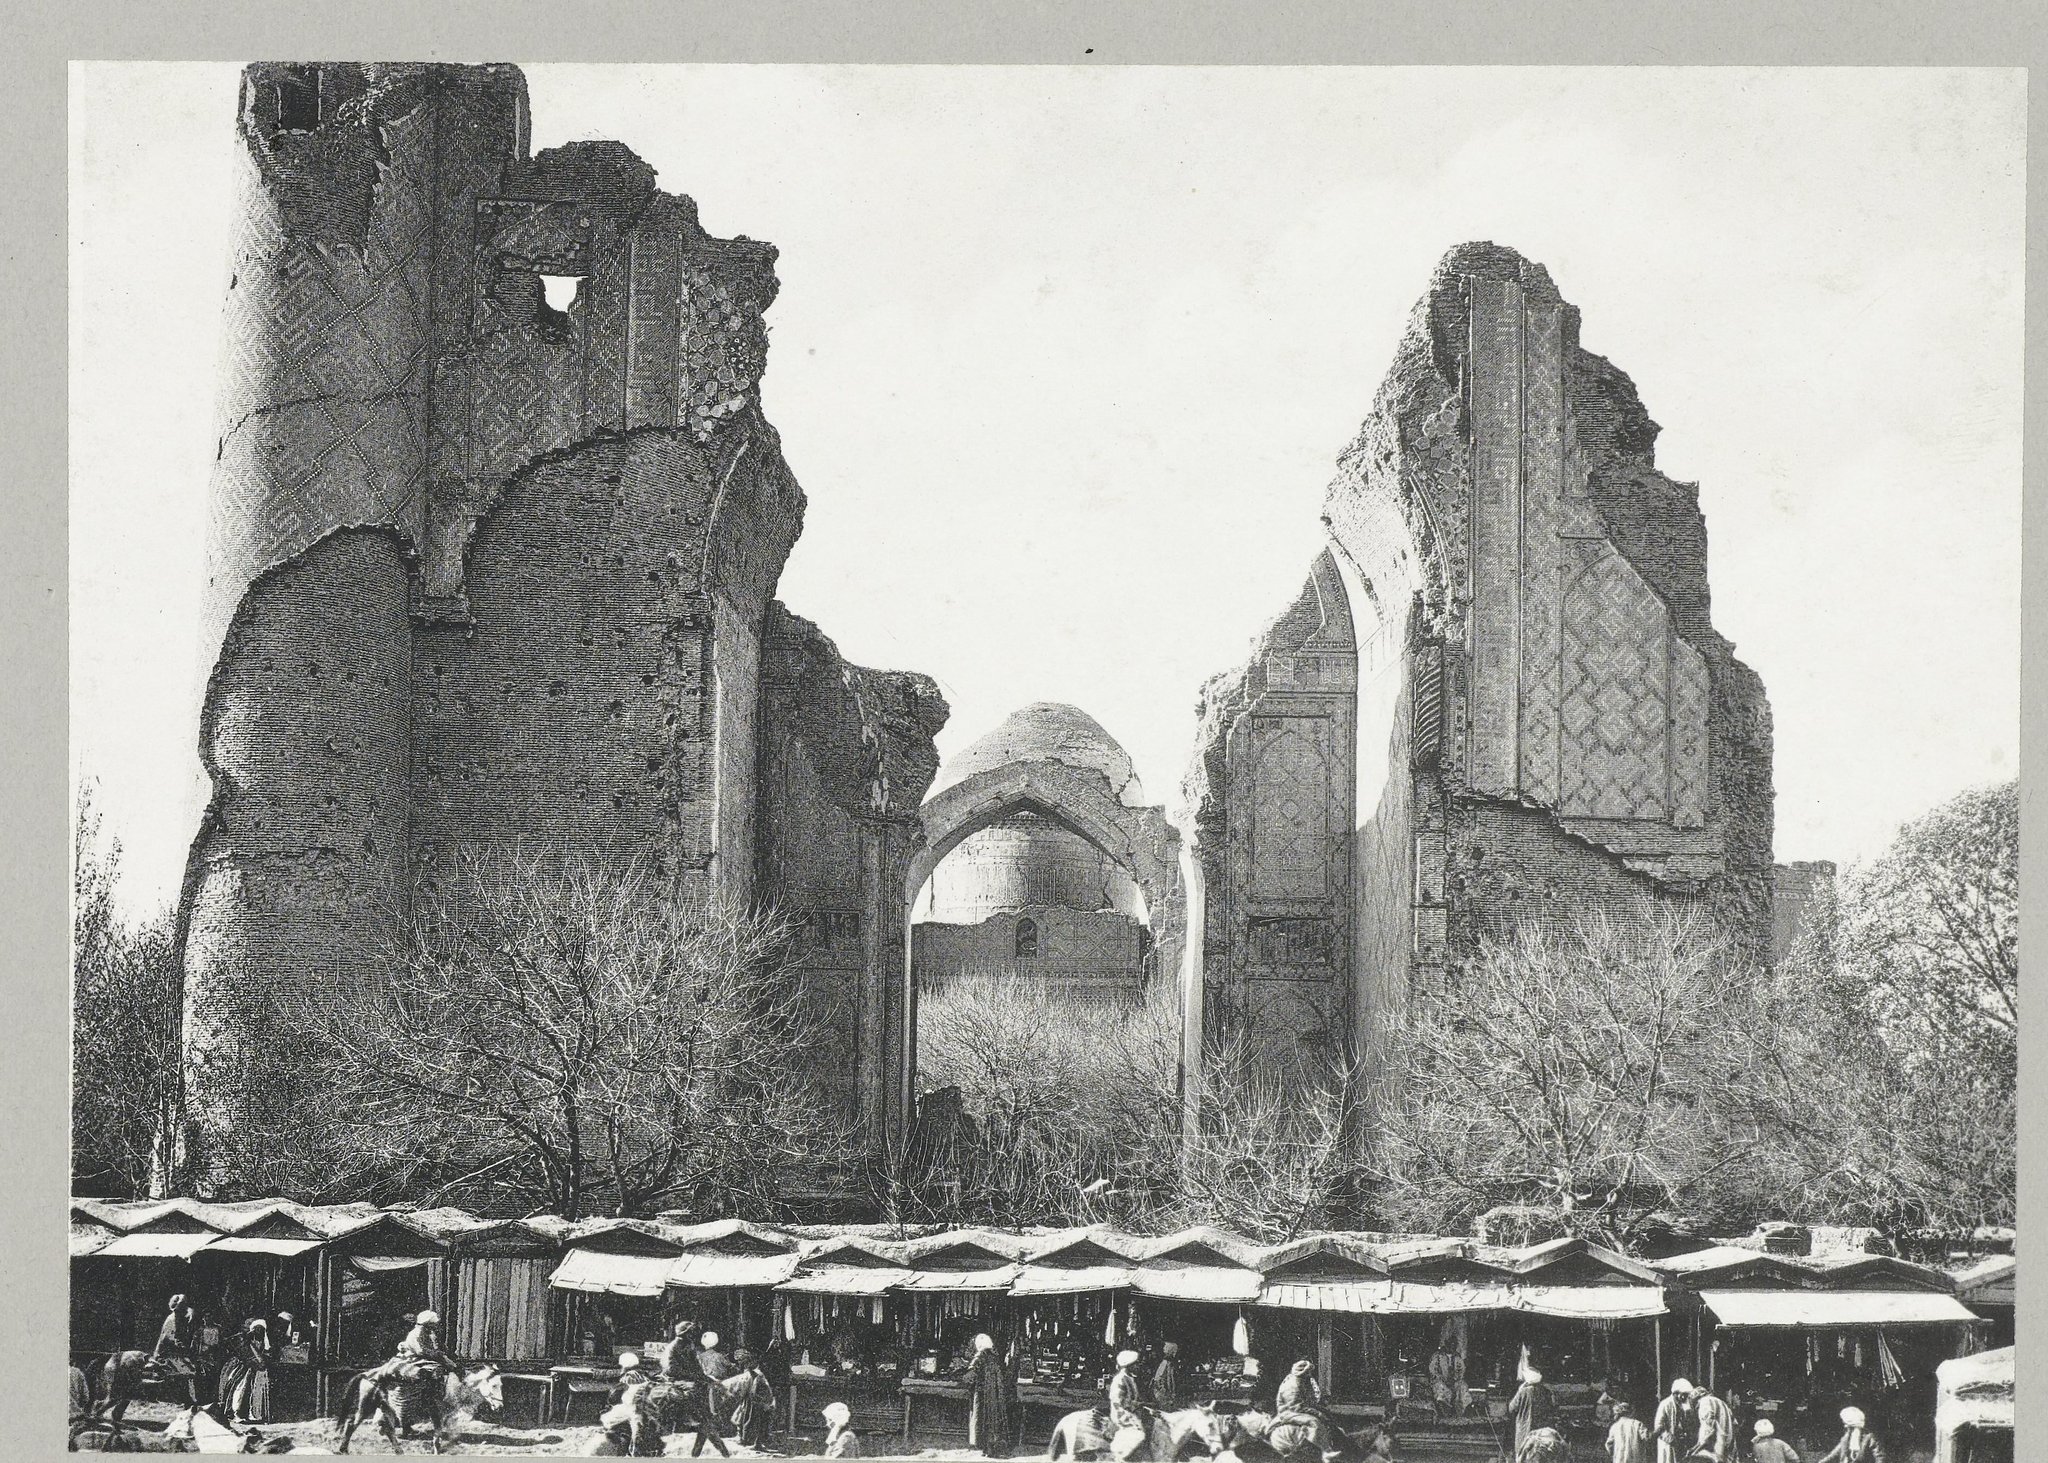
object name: photomechanical print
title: Moskee achter kraampjes met mensen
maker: Anonymous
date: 1895-1915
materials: cardboard, paper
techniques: photograph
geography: samarqand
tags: samarqand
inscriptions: annotation: ‘16. Moskee der favorite van Tamerlan met marmeren lessenaar voor de Koran.’